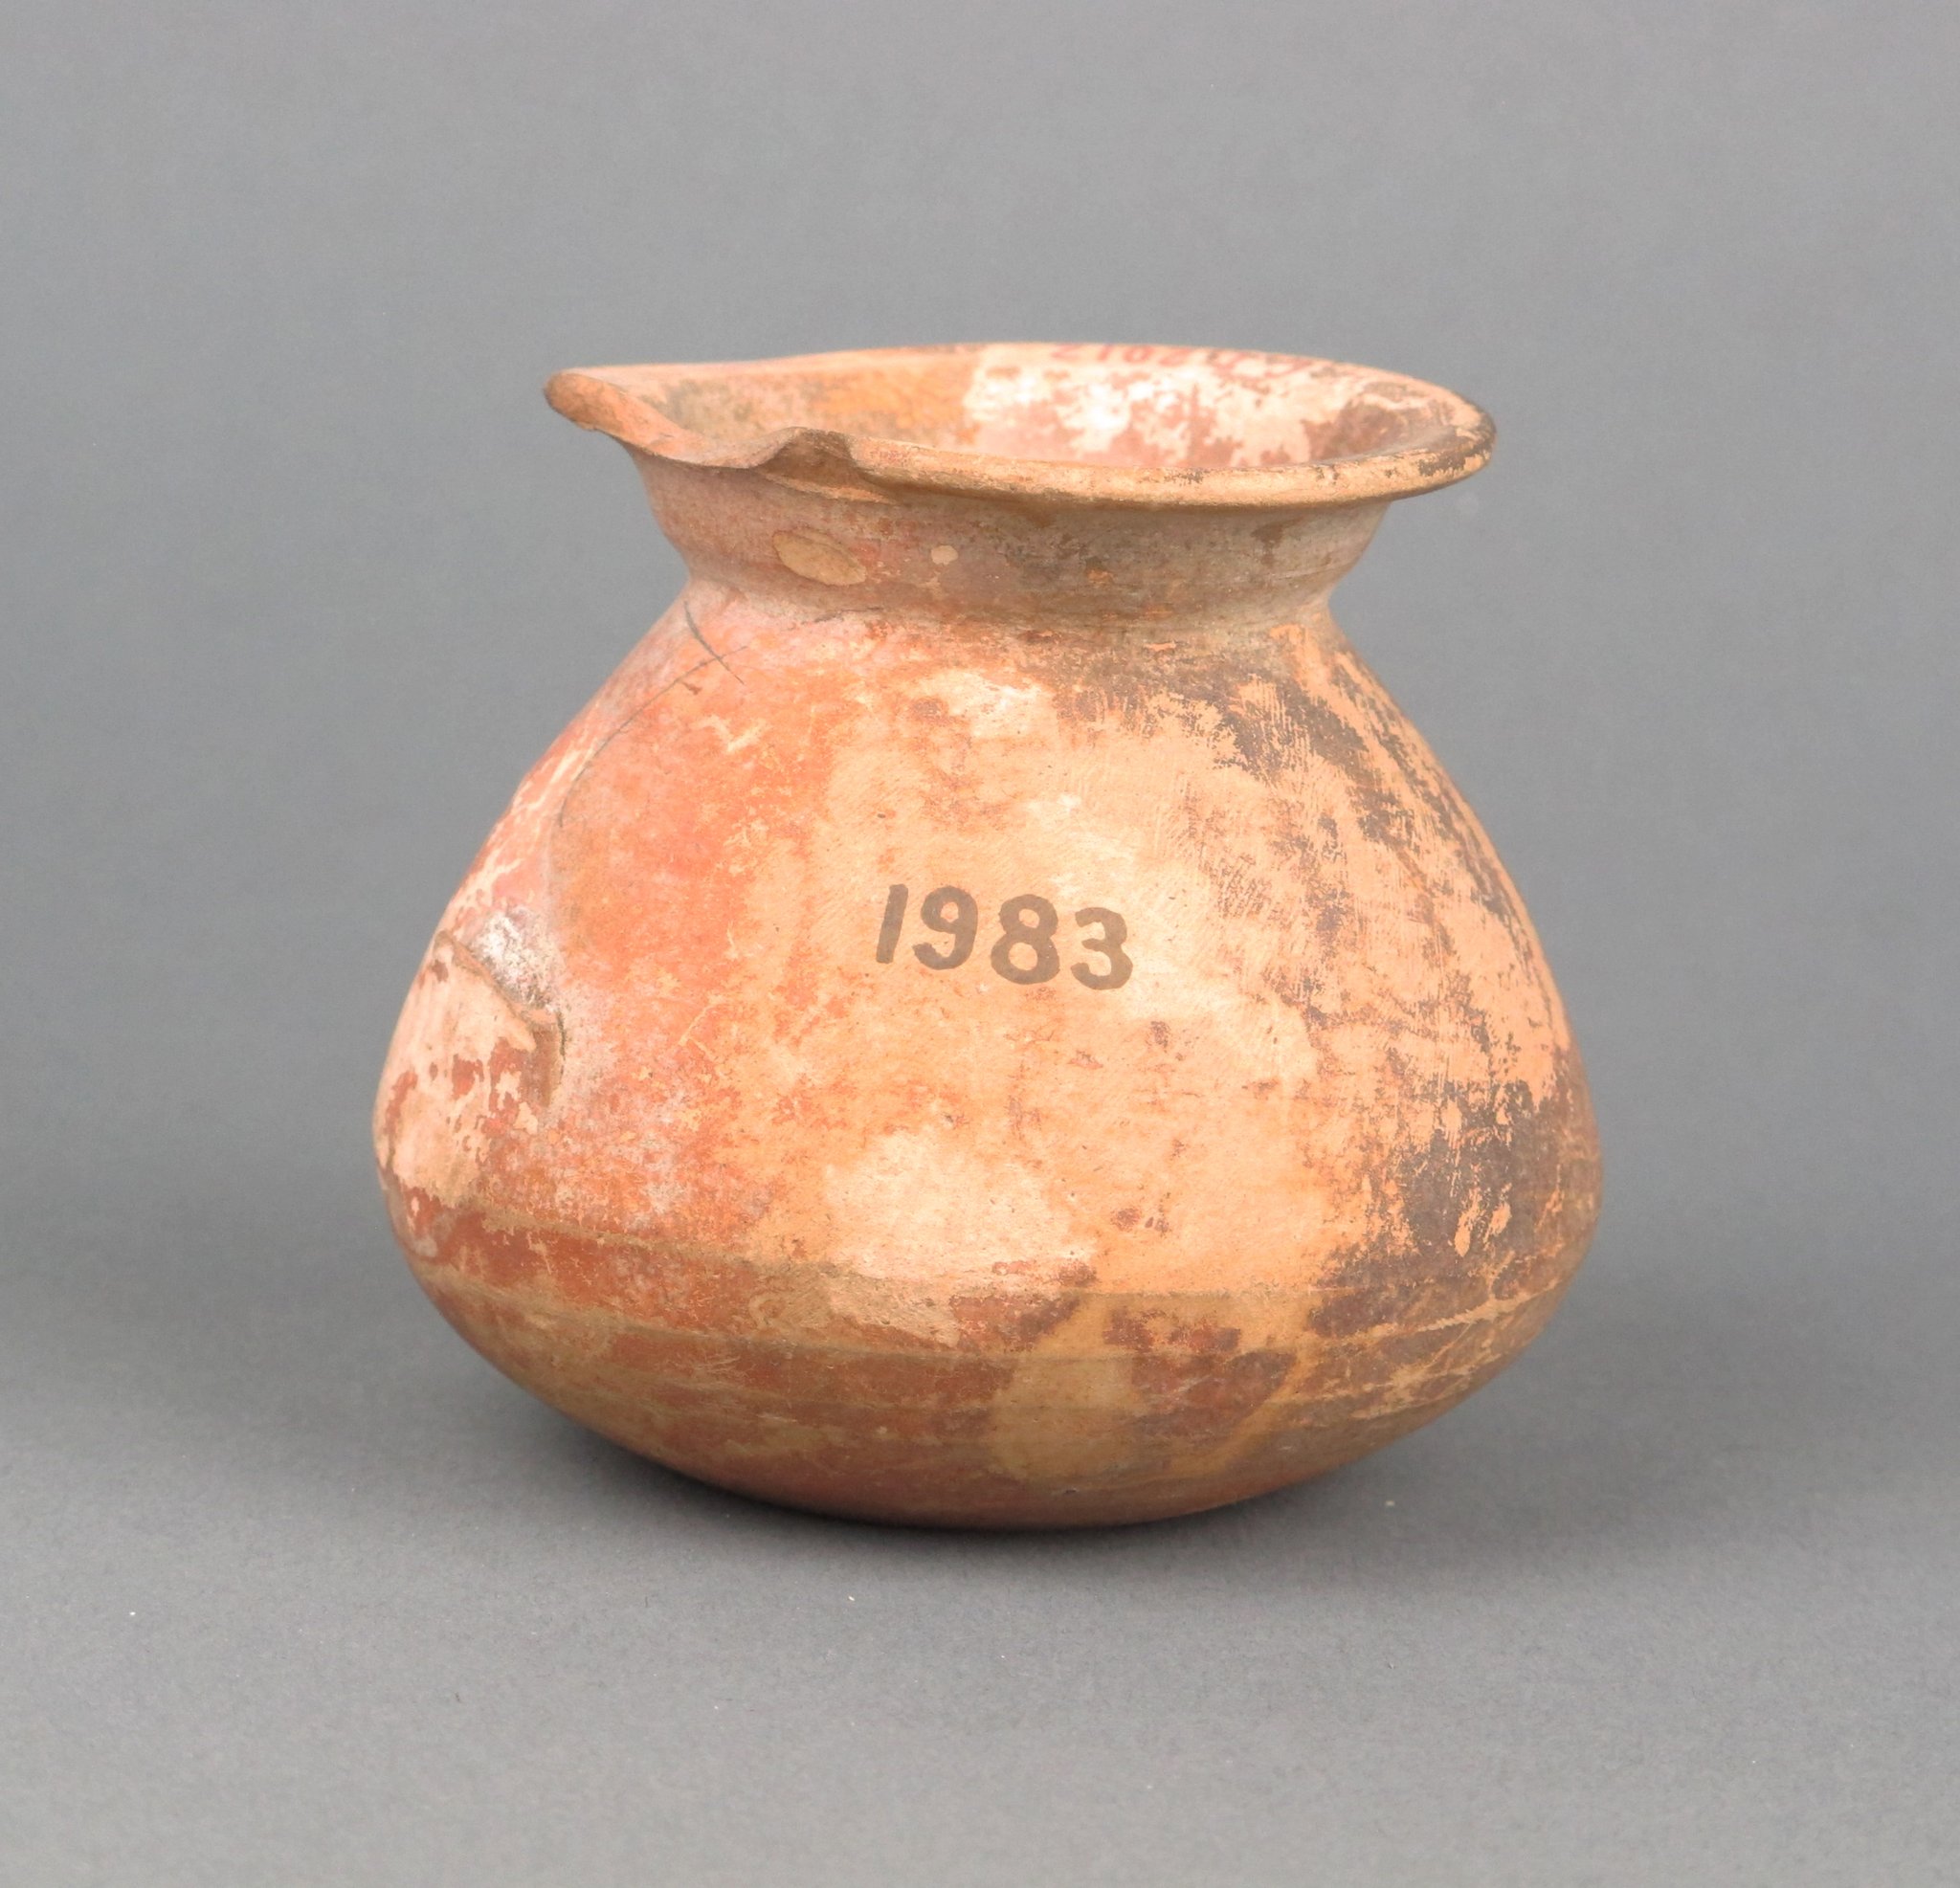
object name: vase, stamped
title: Terracotta juglet with incised letters on base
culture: cypriot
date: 3900 BCE-100 CE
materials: stone